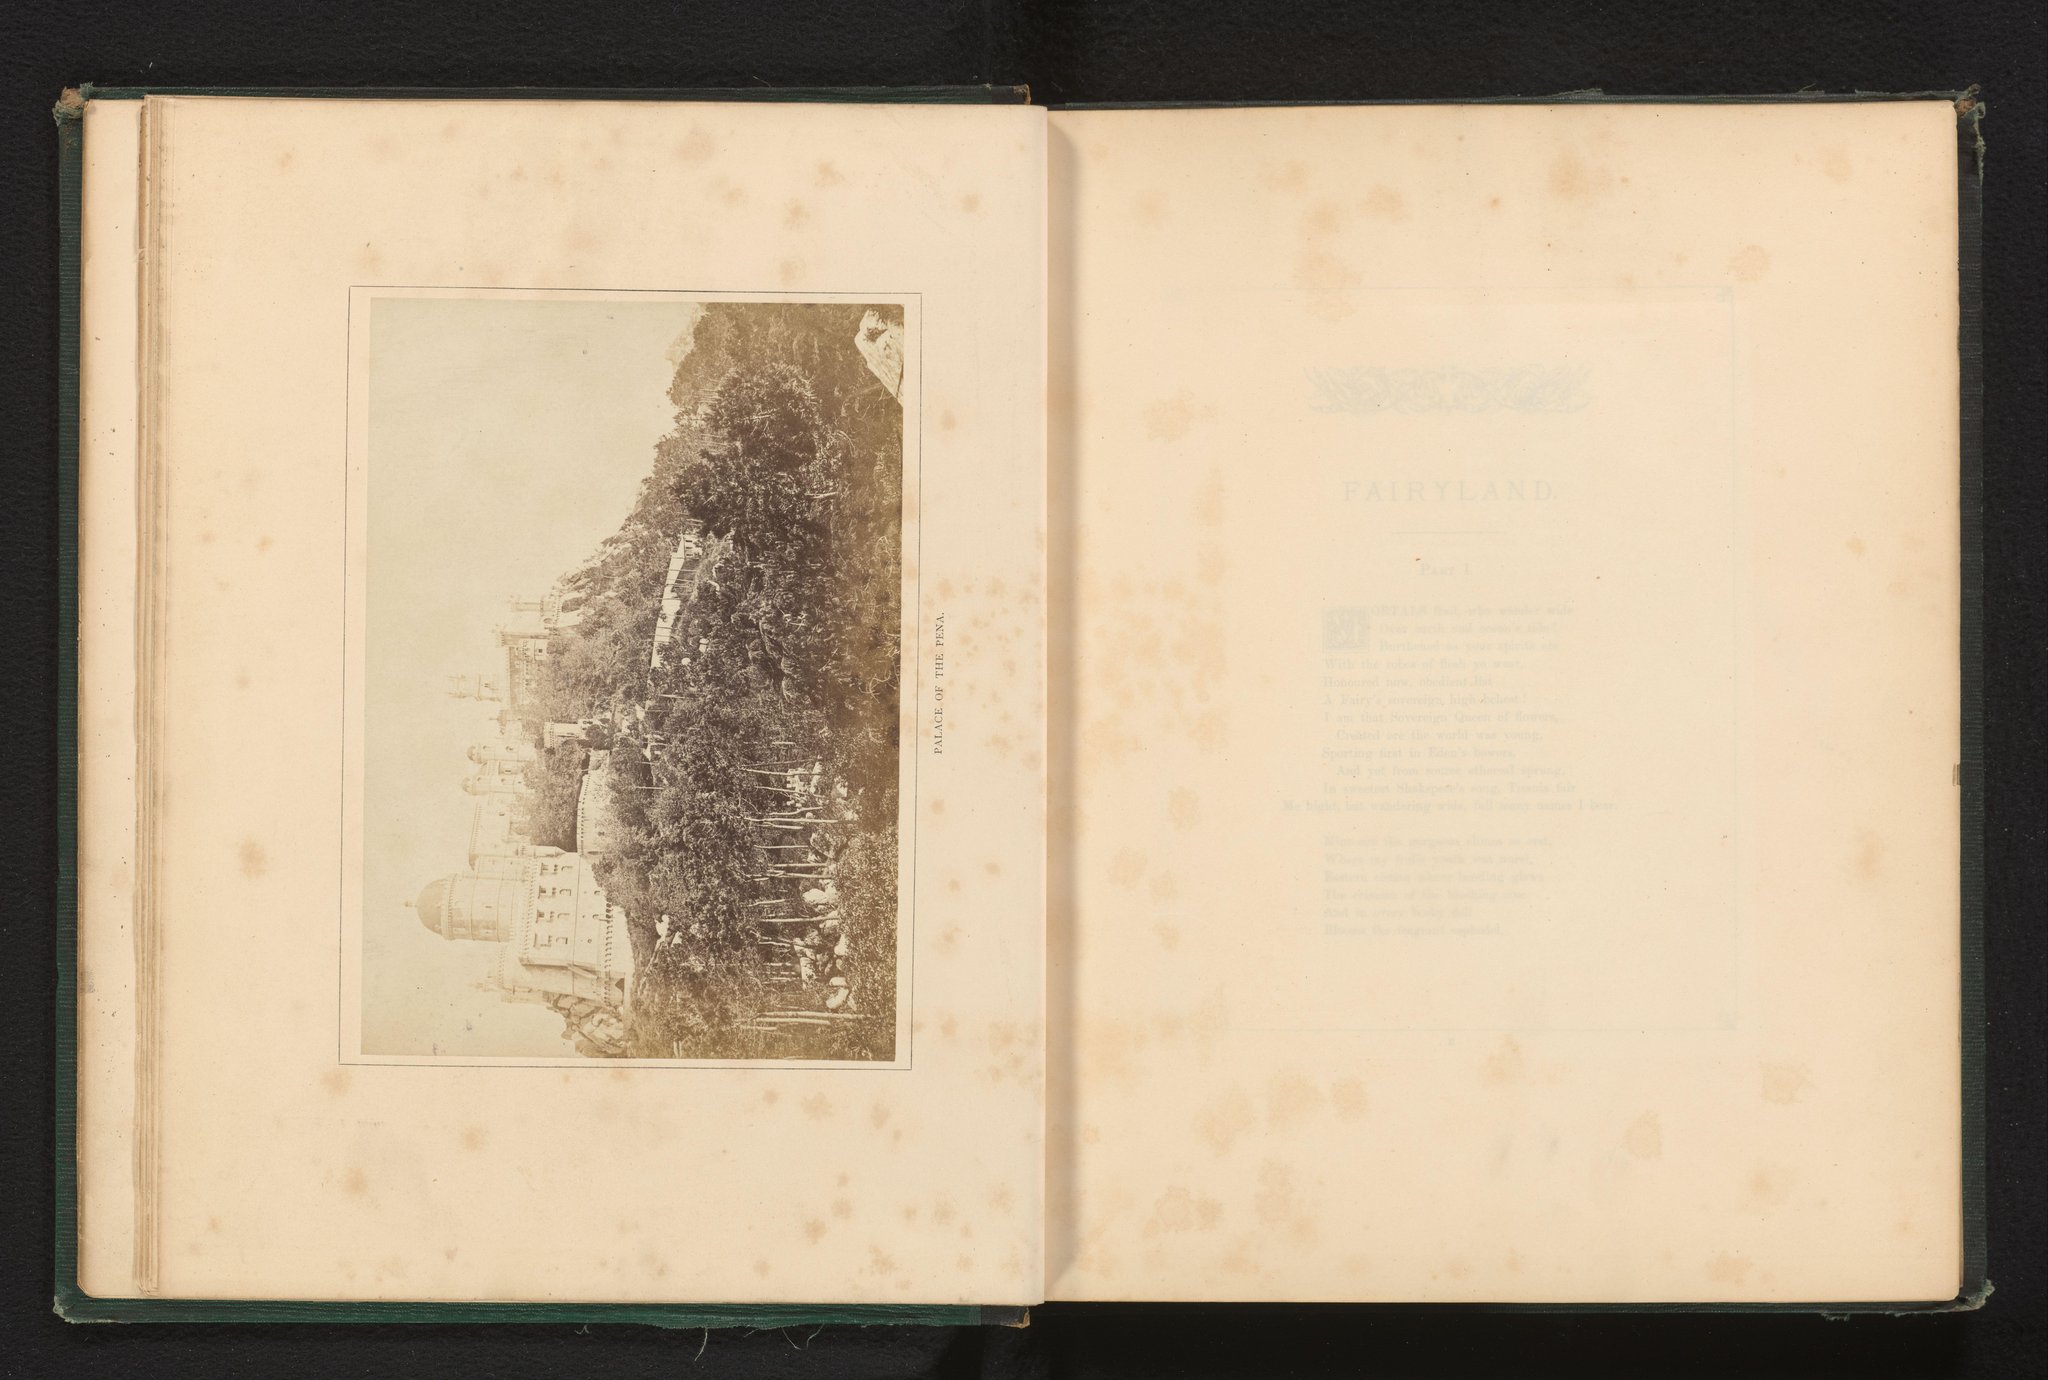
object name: page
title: Gezicht op het Palácio da Pena bij Sintra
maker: Anonymous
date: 1865-1870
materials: paper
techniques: albumen print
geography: sintra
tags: palace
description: Foto op vierde ongenummerde pagina na pagina xviii.